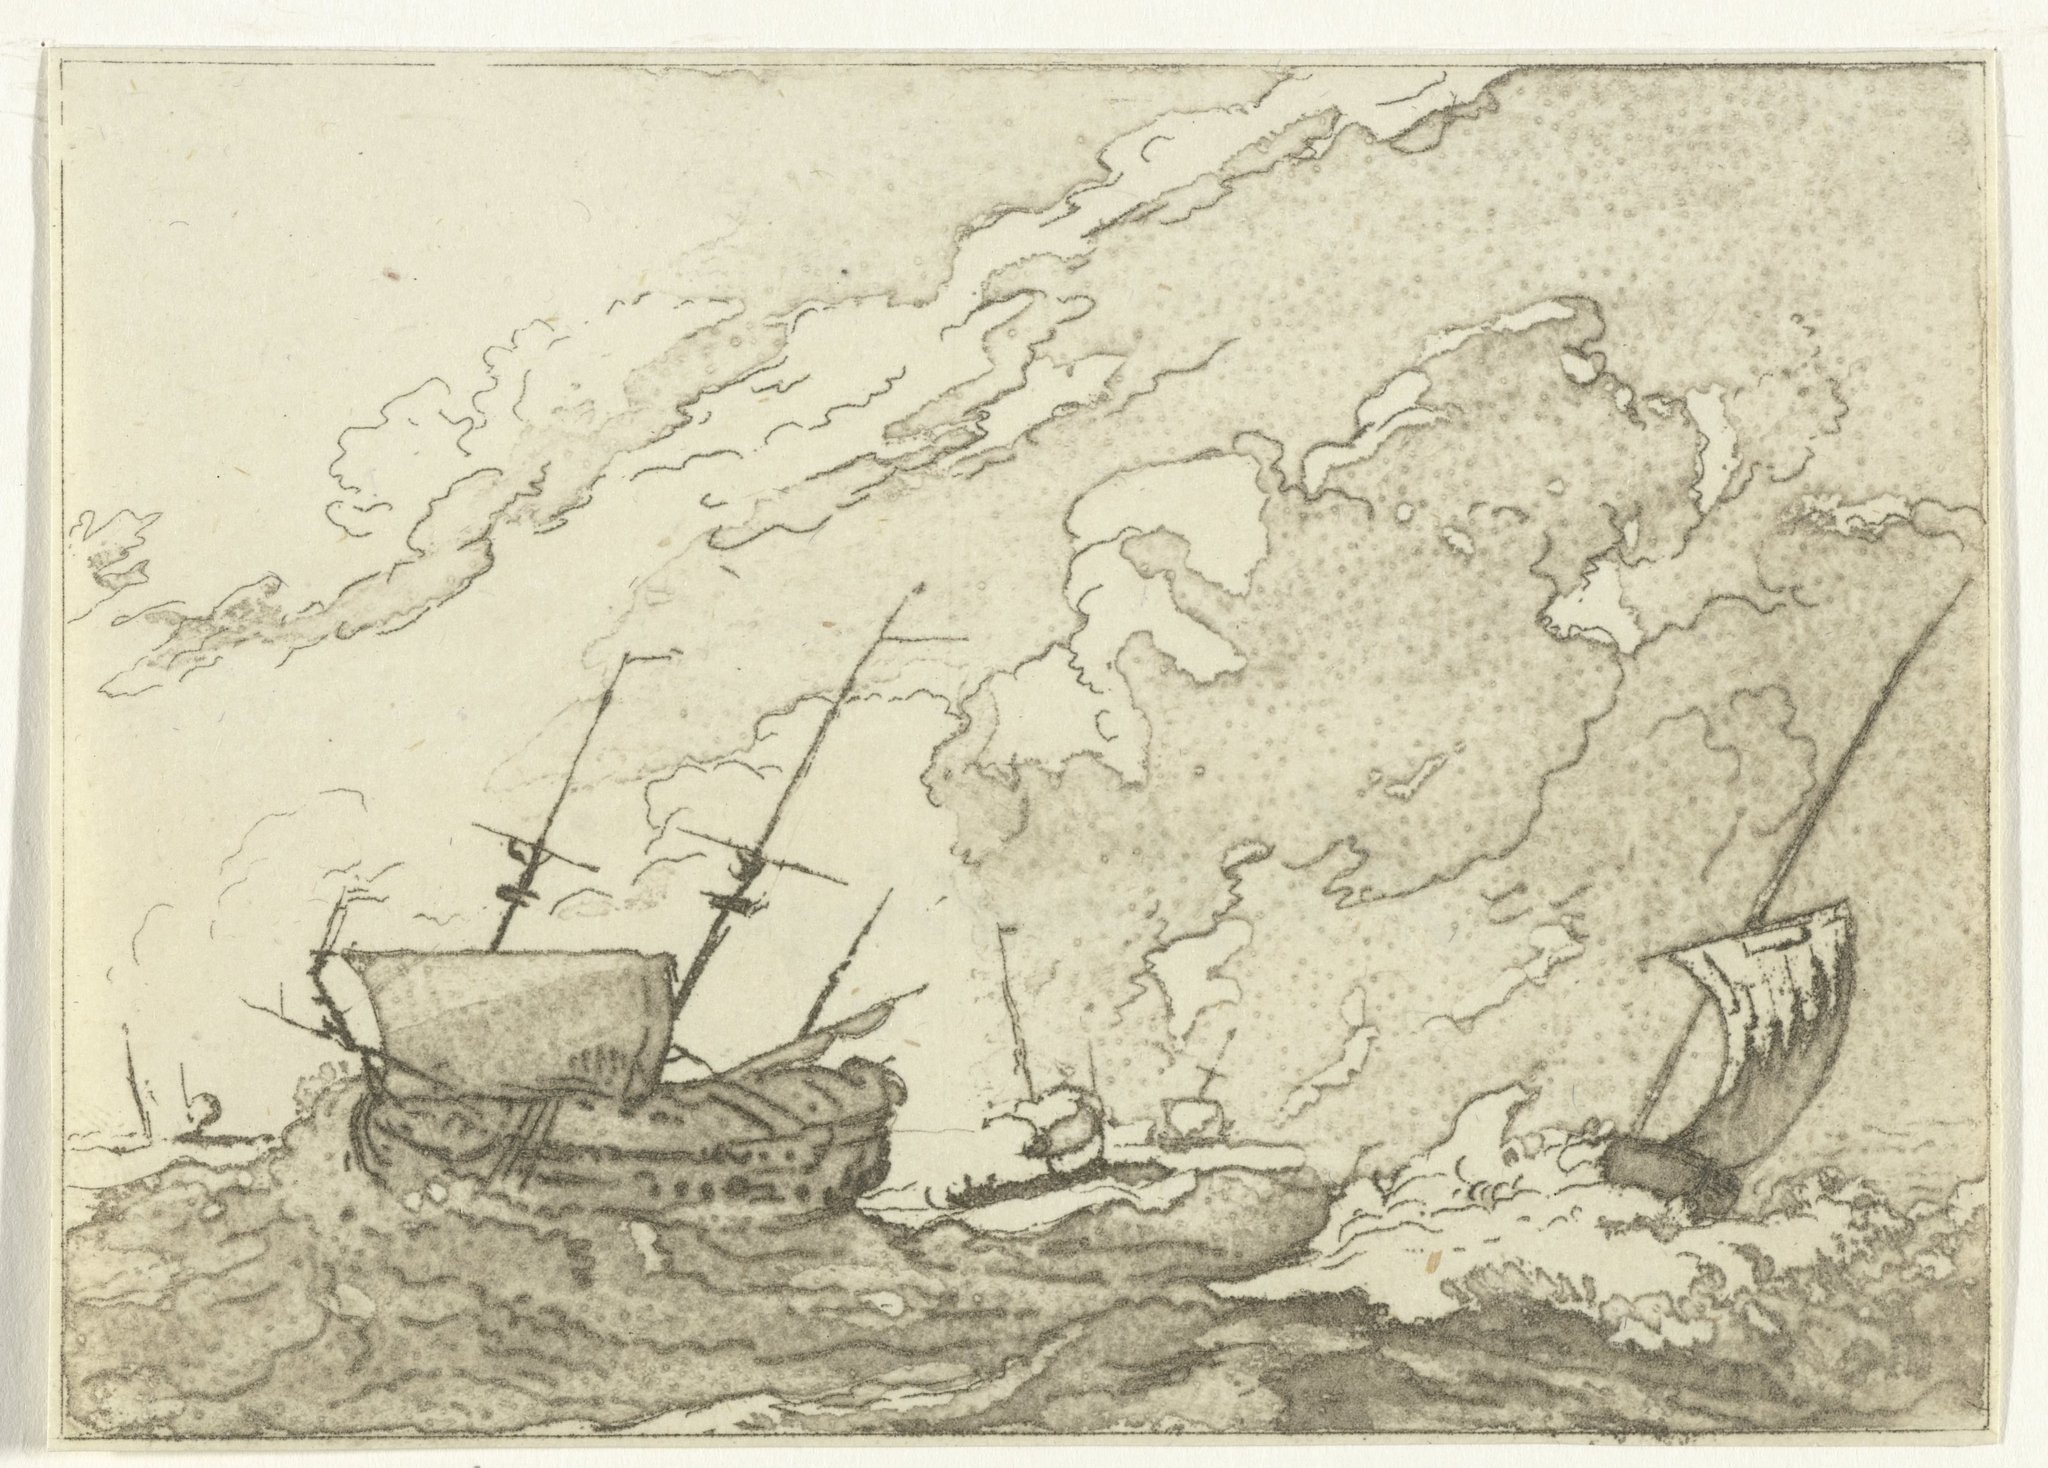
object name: print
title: Schepen in een storm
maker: jacob ernst marcus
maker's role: draughtsman, print maker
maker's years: 1774-1826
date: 1784-1826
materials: paper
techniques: aquatint, etching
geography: amsterdam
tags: ships (in general), storm at sea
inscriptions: collector's mark: Lugt 2228